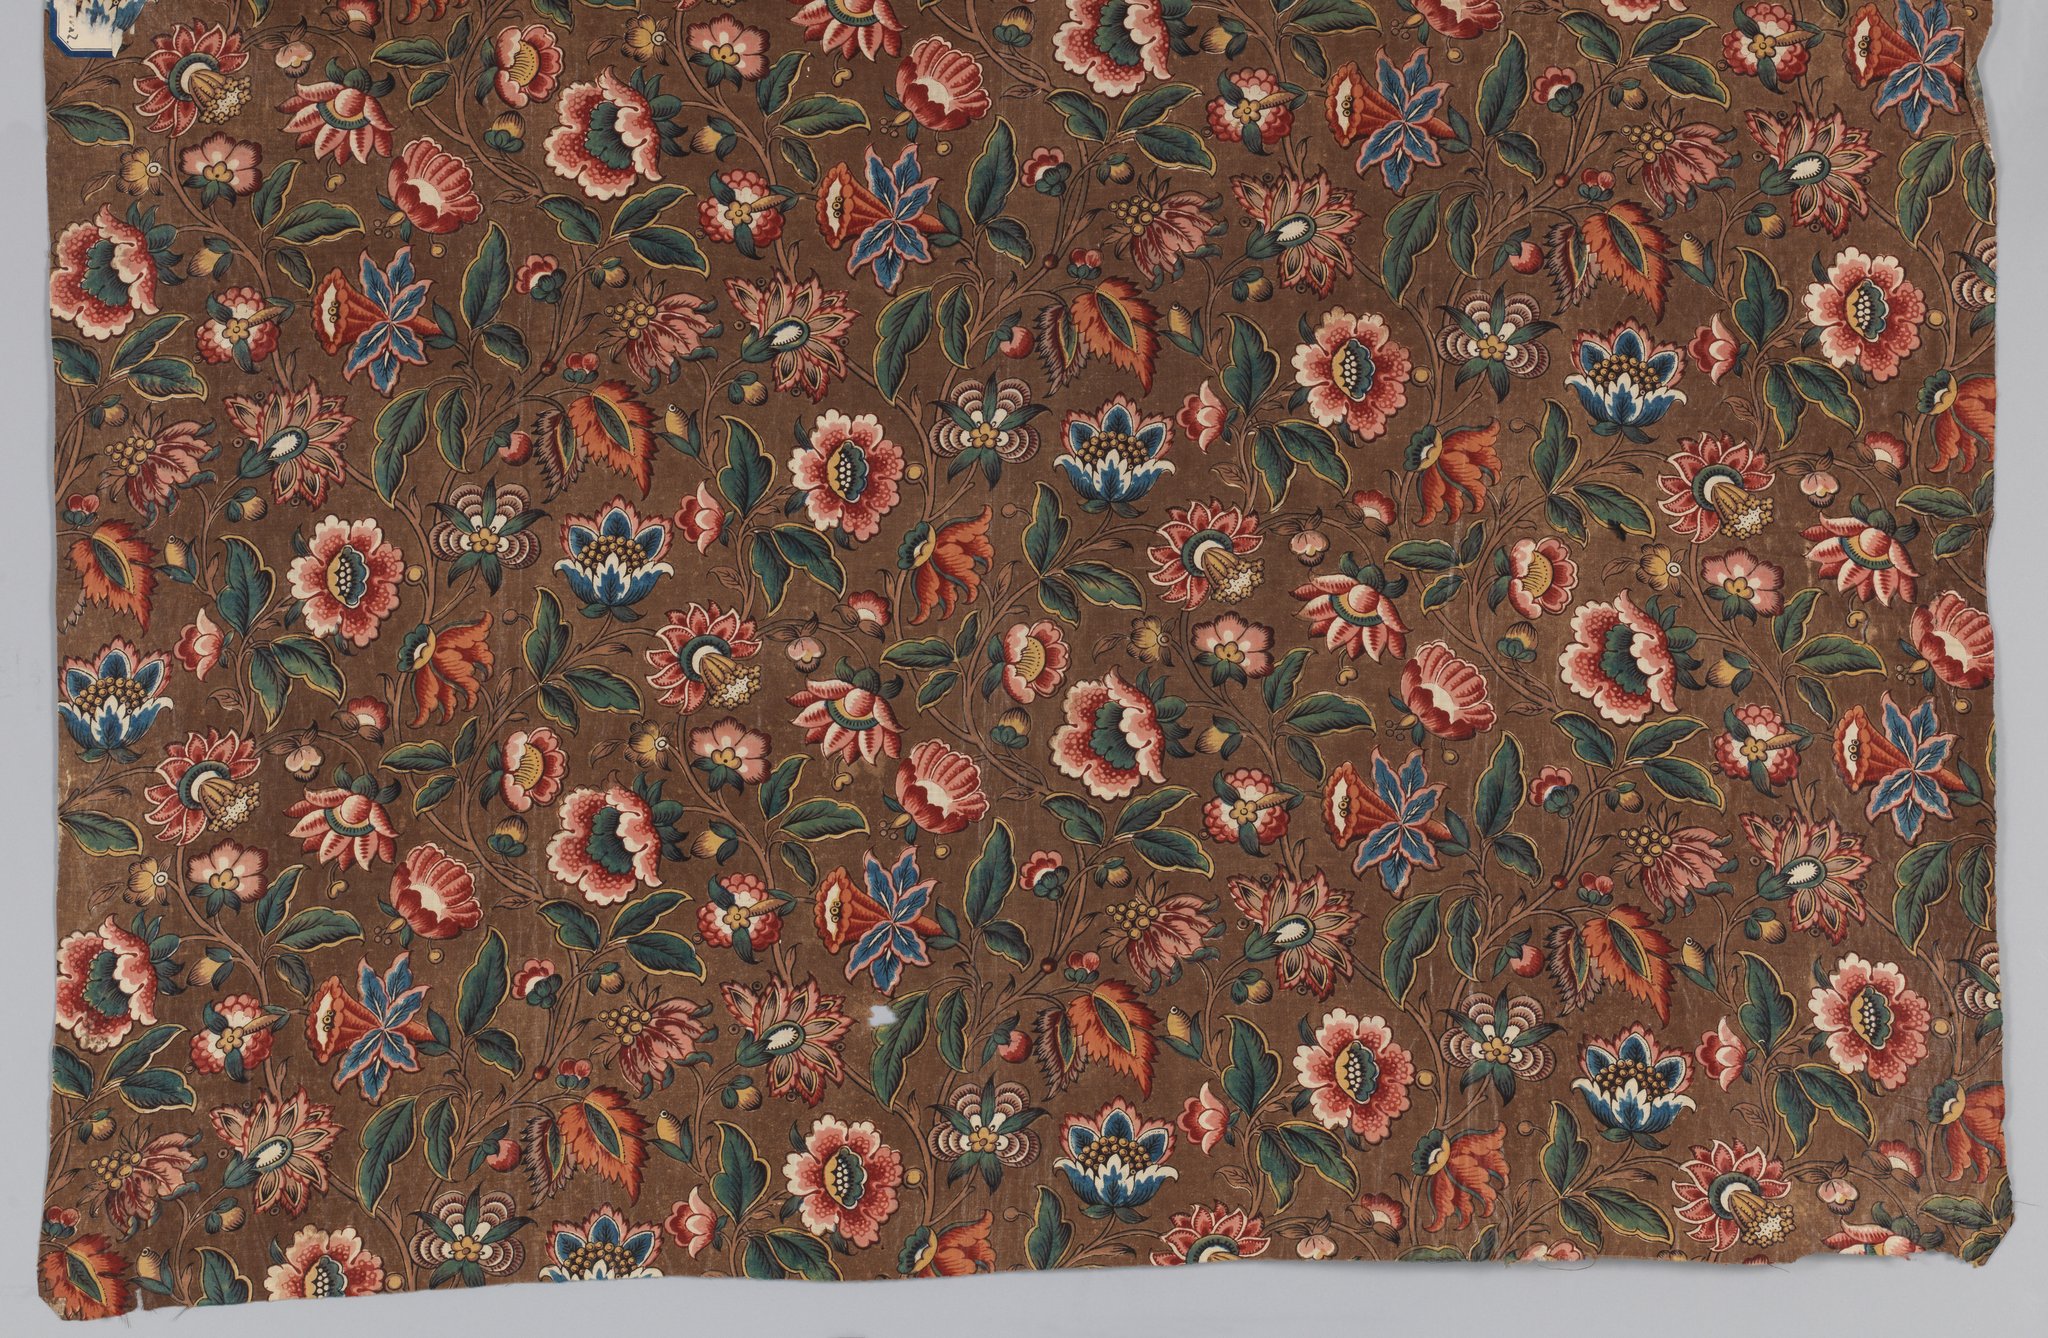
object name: piece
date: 1805-1810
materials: cotton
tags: flowers,leaves